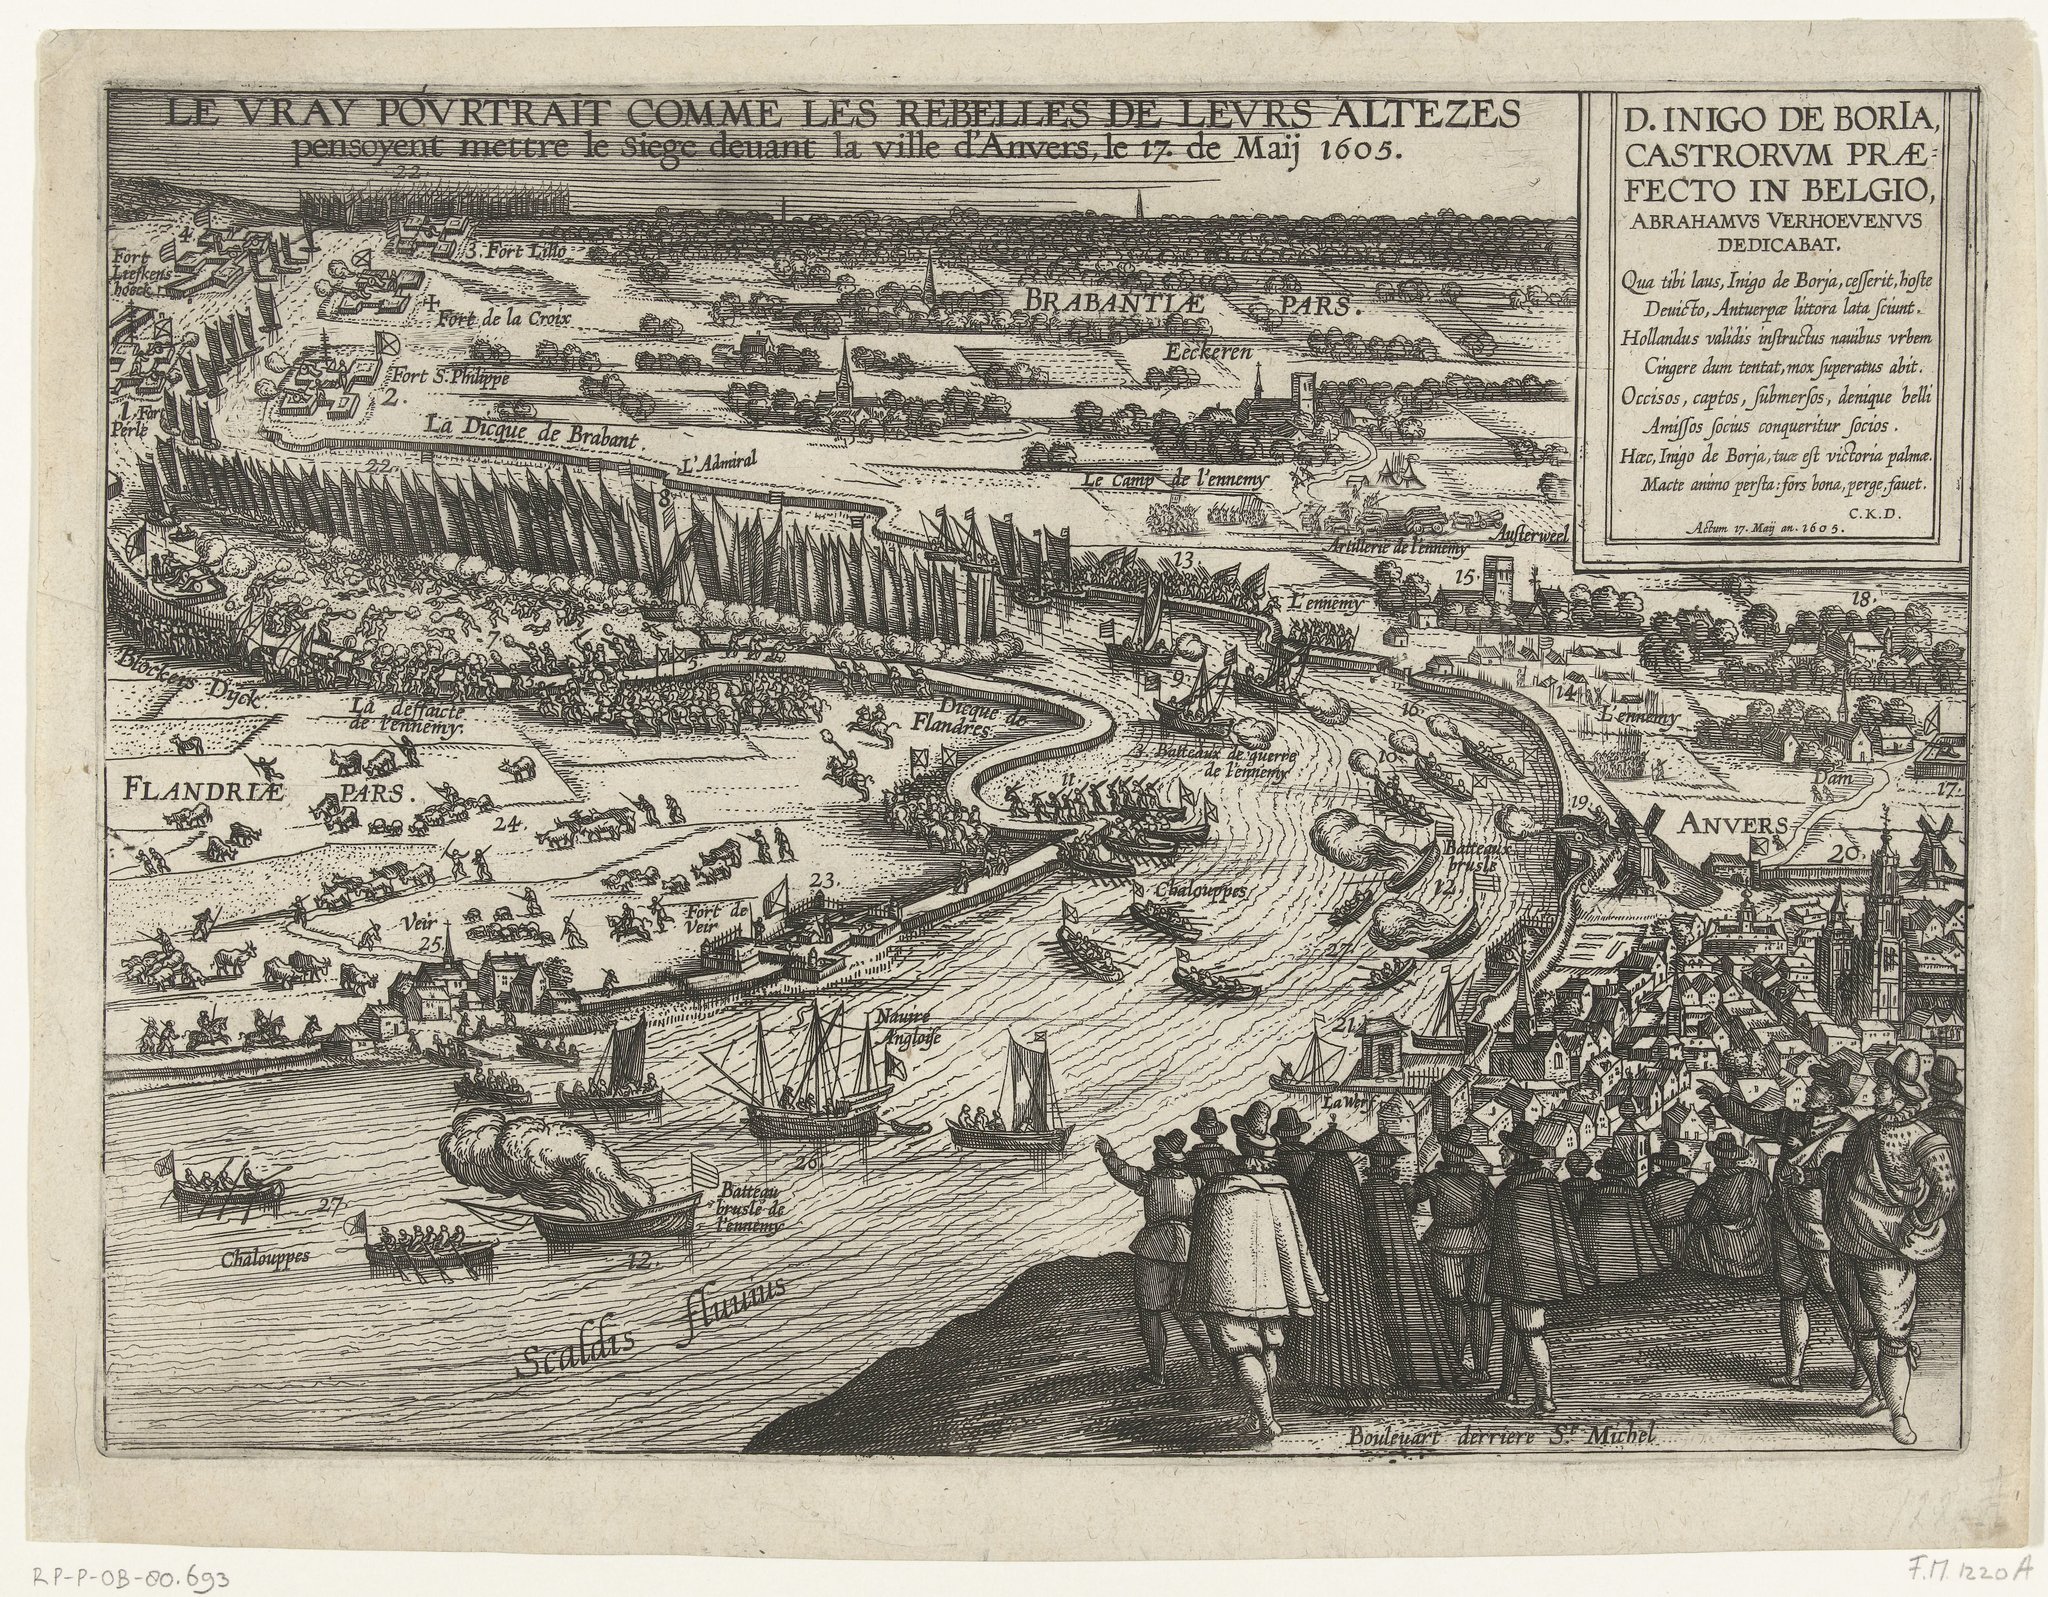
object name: print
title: Mislukte aanslag op Antwerpen, 1605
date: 1605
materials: paper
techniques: engraving, etching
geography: southern netherlands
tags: ernst casimir graaf van nassau-dietz, battle (+ land forces), antwerp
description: De mislukte aanslag op Antwerpen uitgevoerd door een Staatse vloot onder bevel van graaf Ernst Casimir van Nassau, 17 mei 1605. De Staatse vloot op de Schelde wordt beschoten vanuit de forten en stellingen langs de oevers. Linksboven zware gevechten bij de Blokkersdijk. Op de voorgrond kijken Antwerpenaren naar de gevechten. Rechtsboven een cartouche met de opdracht en een vers in het Latijn.